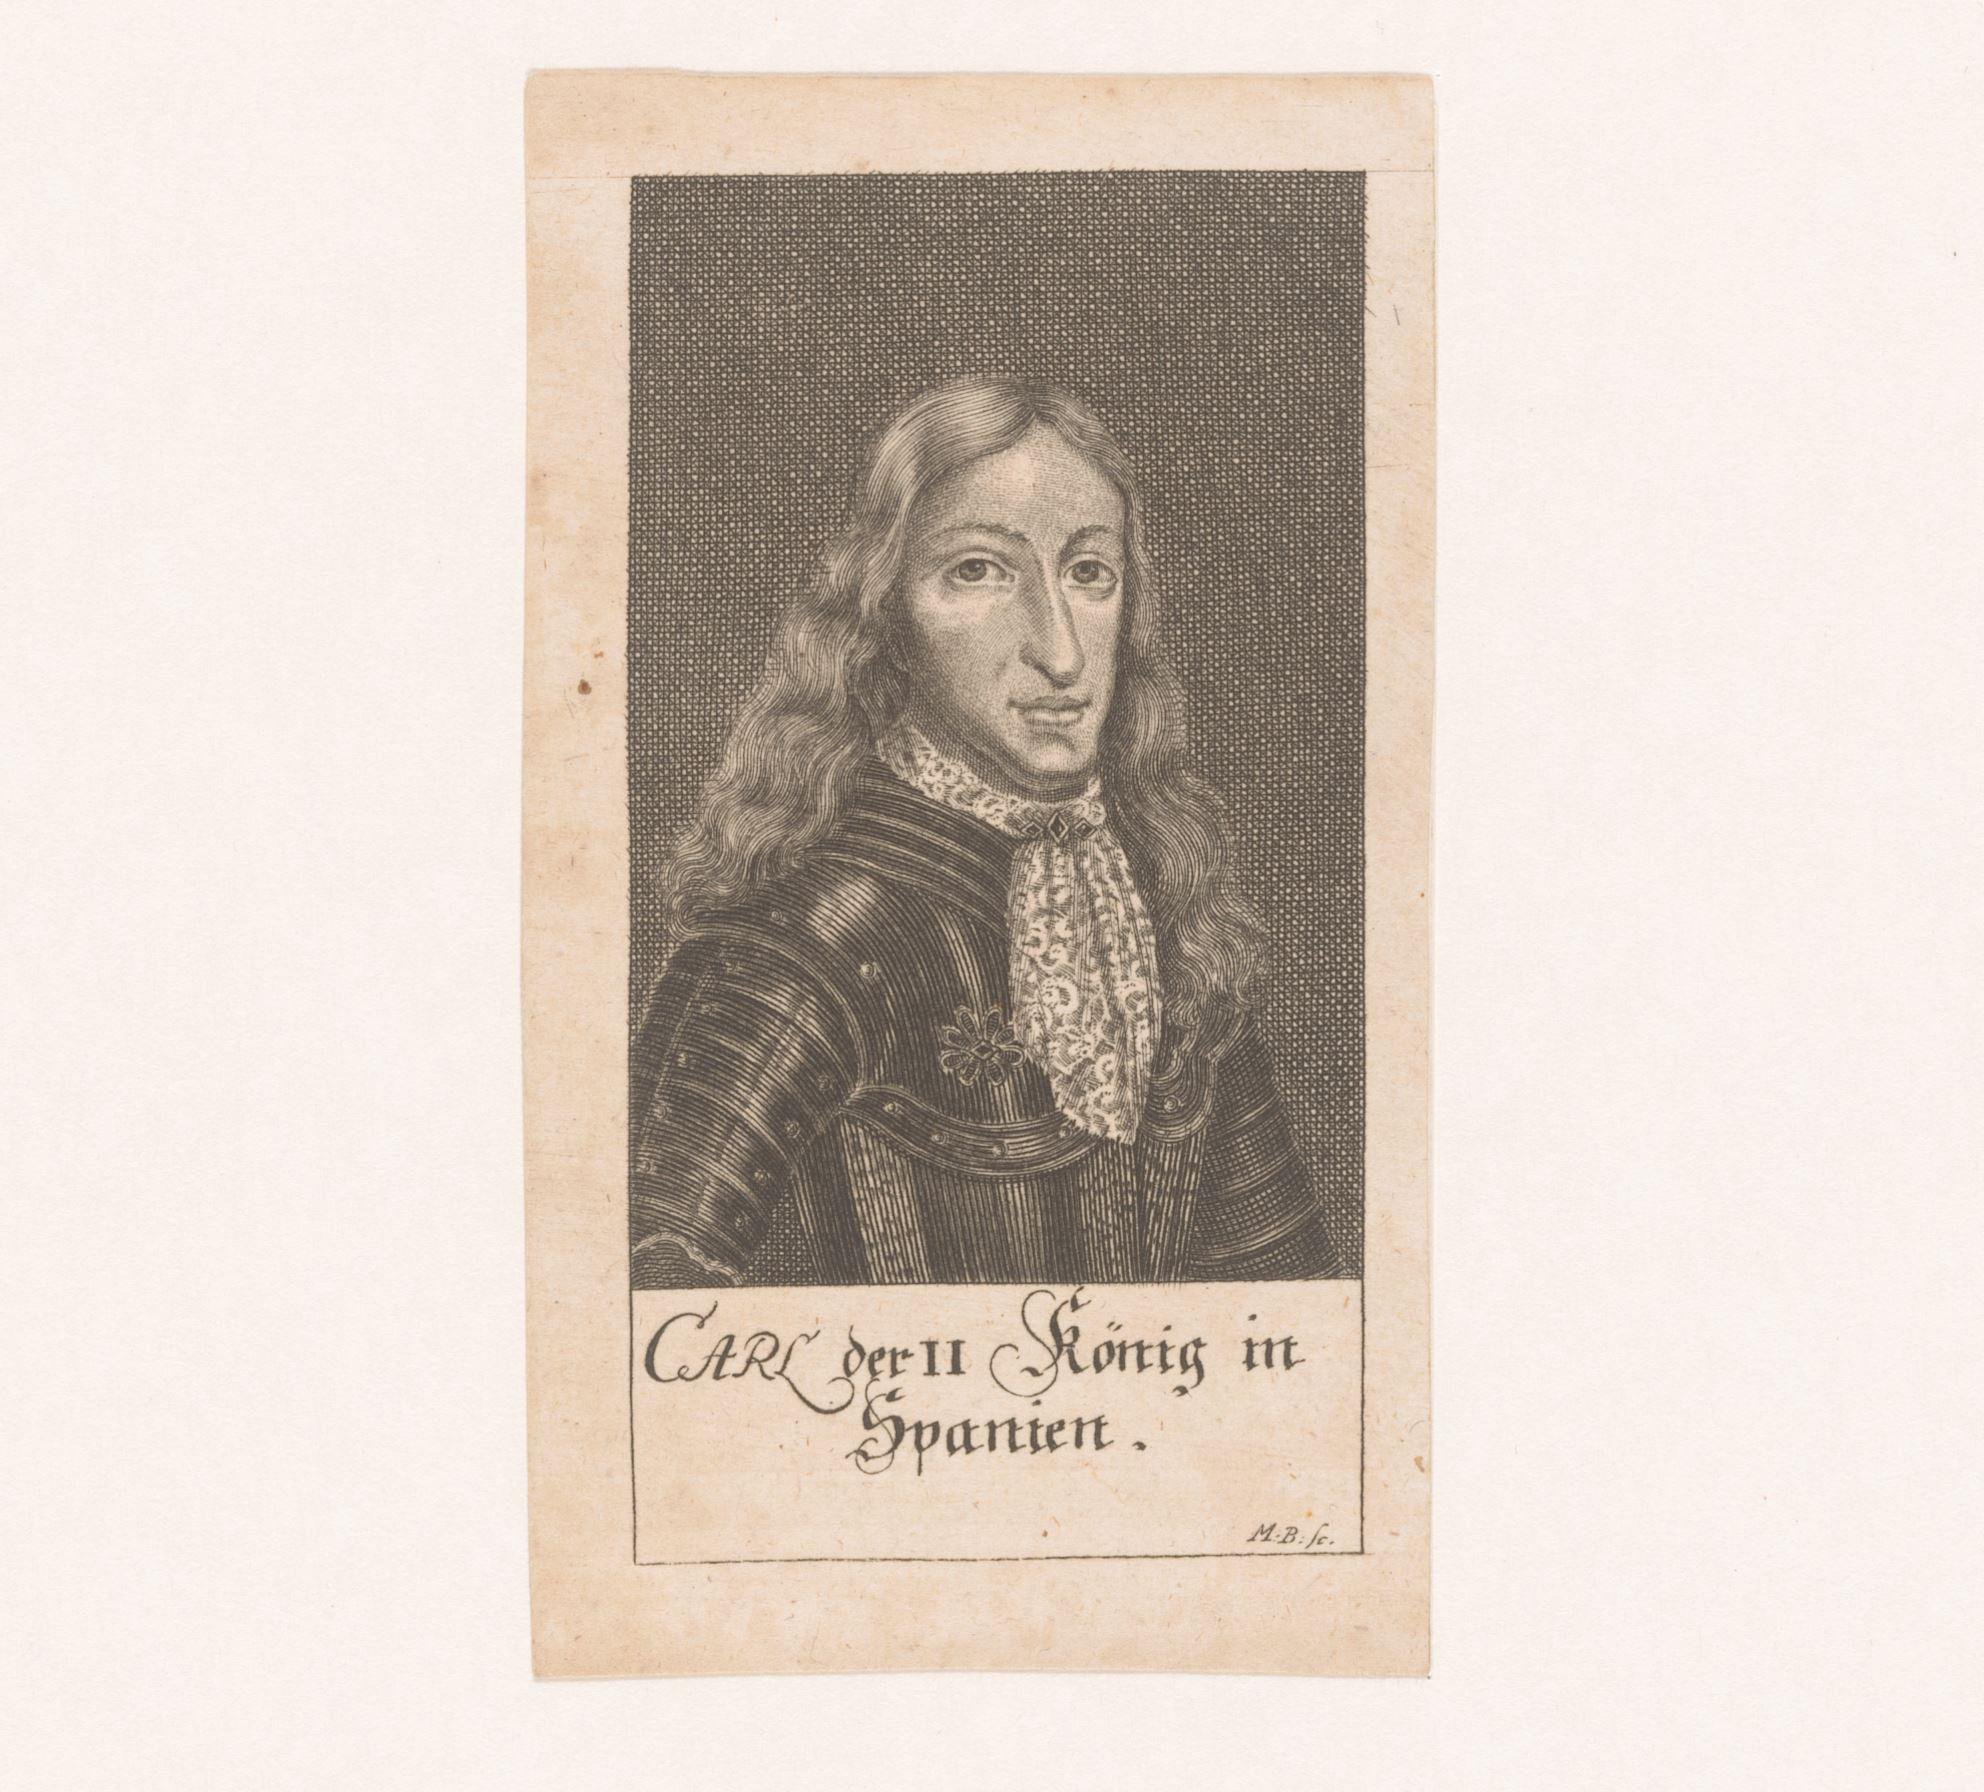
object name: print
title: Portret van Karel II, koning van Spanje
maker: monogrammist mb (duitsland)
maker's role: print maker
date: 1665-1749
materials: paper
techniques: engraving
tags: karel ii (koning van spanje), historical persons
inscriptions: collector's mark: Lugt 2228